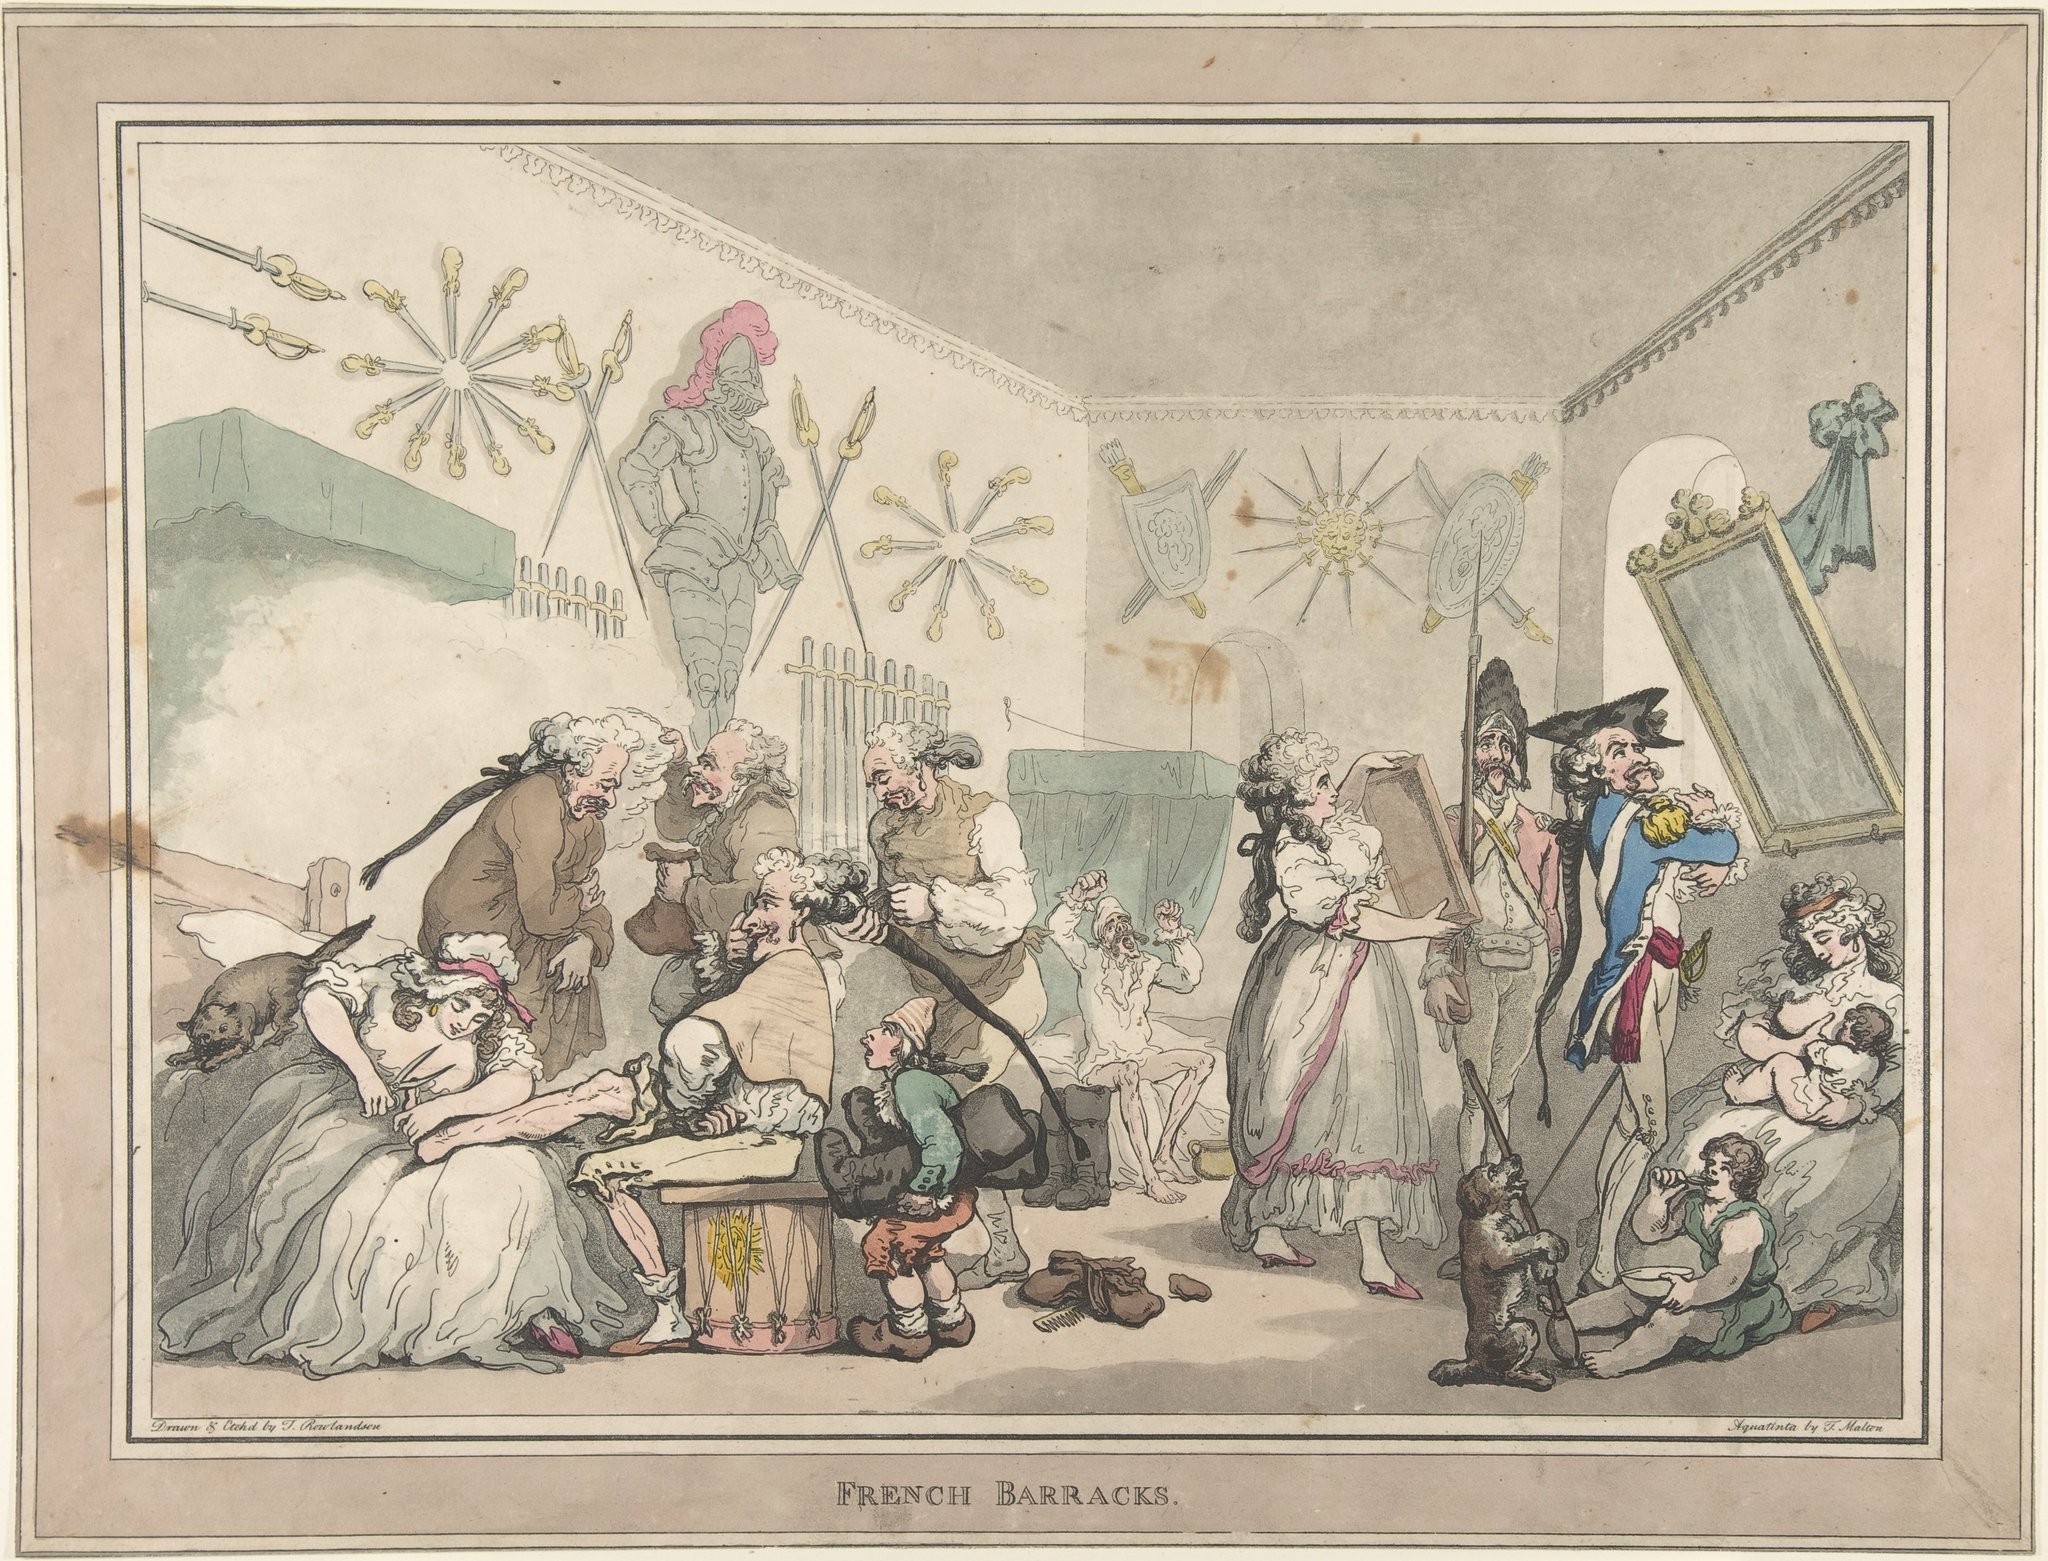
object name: print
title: French Barracks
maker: thomas rowlandson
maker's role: artist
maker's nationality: british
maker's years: 1757-1827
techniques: aquatint, etching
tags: satire,infants,men,women,dogs,dressing